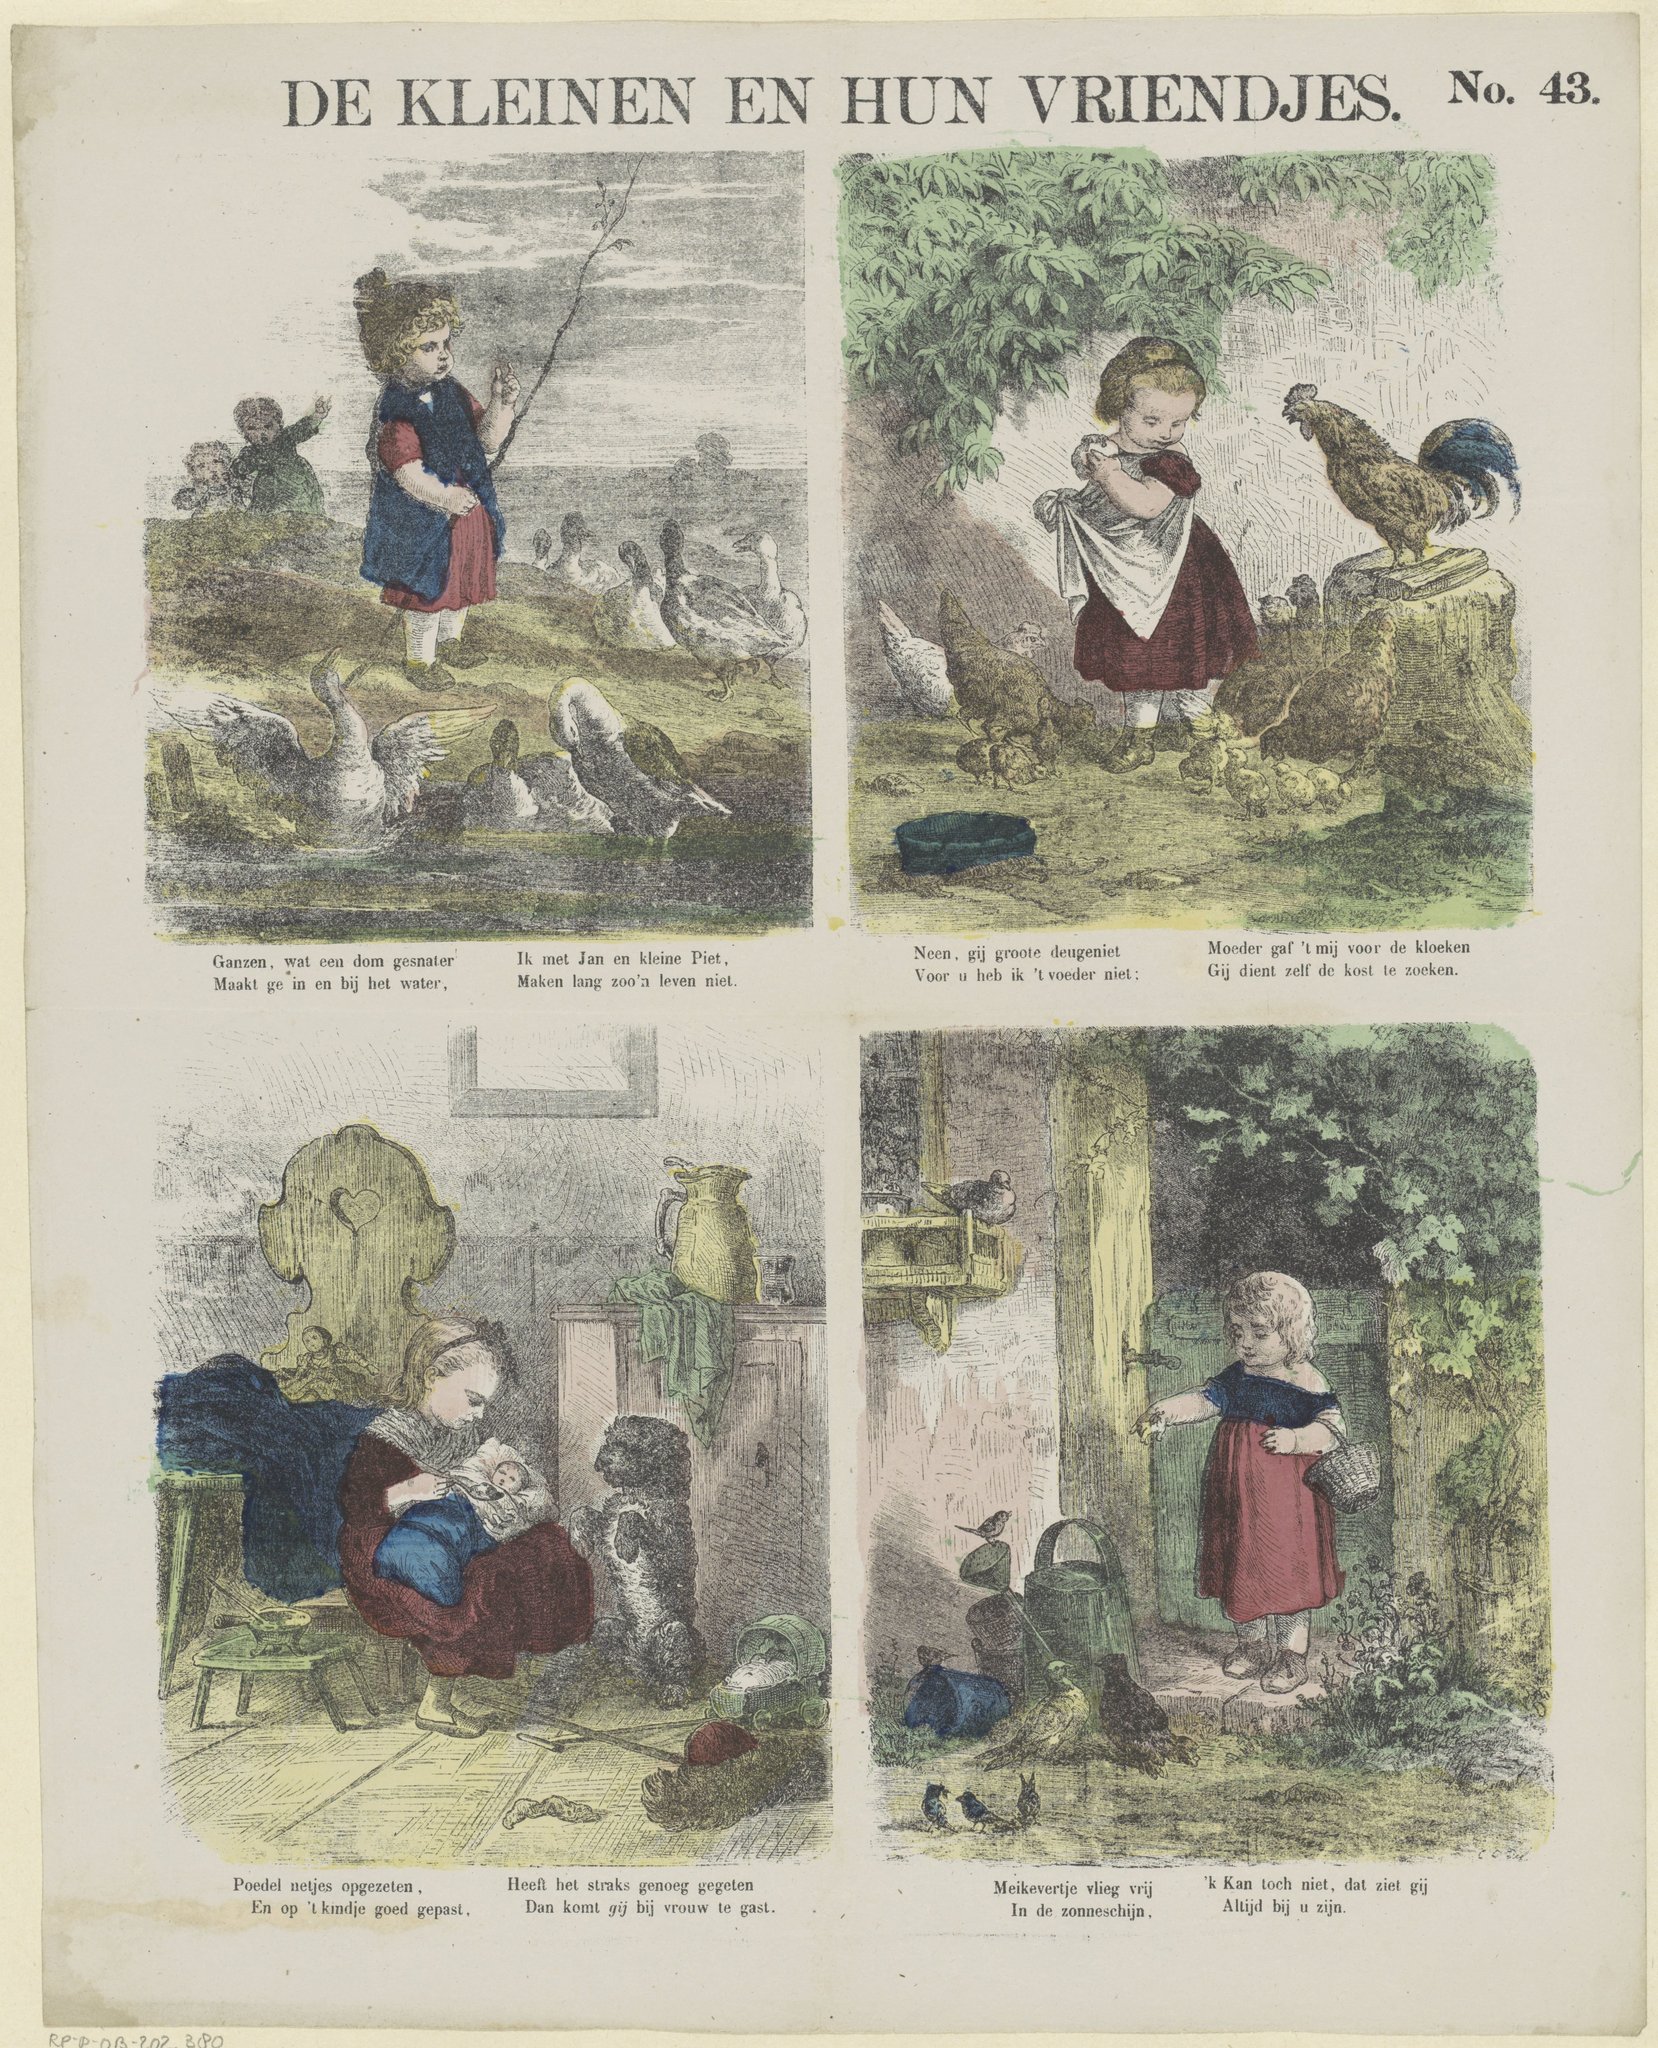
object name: popular print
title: Meijer's prenten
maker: Anonymous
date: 1874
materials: paper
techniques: colour, letterpress printing, lithograph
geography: amsterdam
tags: animals, child, child playing with animals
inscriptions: collector's mark: Lugt 2760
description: Blad met 4 voorstellingen van kinderen die met dieren spelen. Onder elke afbeelding een vierregelig vers in twee kolommen. Genummerd rechtsboven: No. 43.